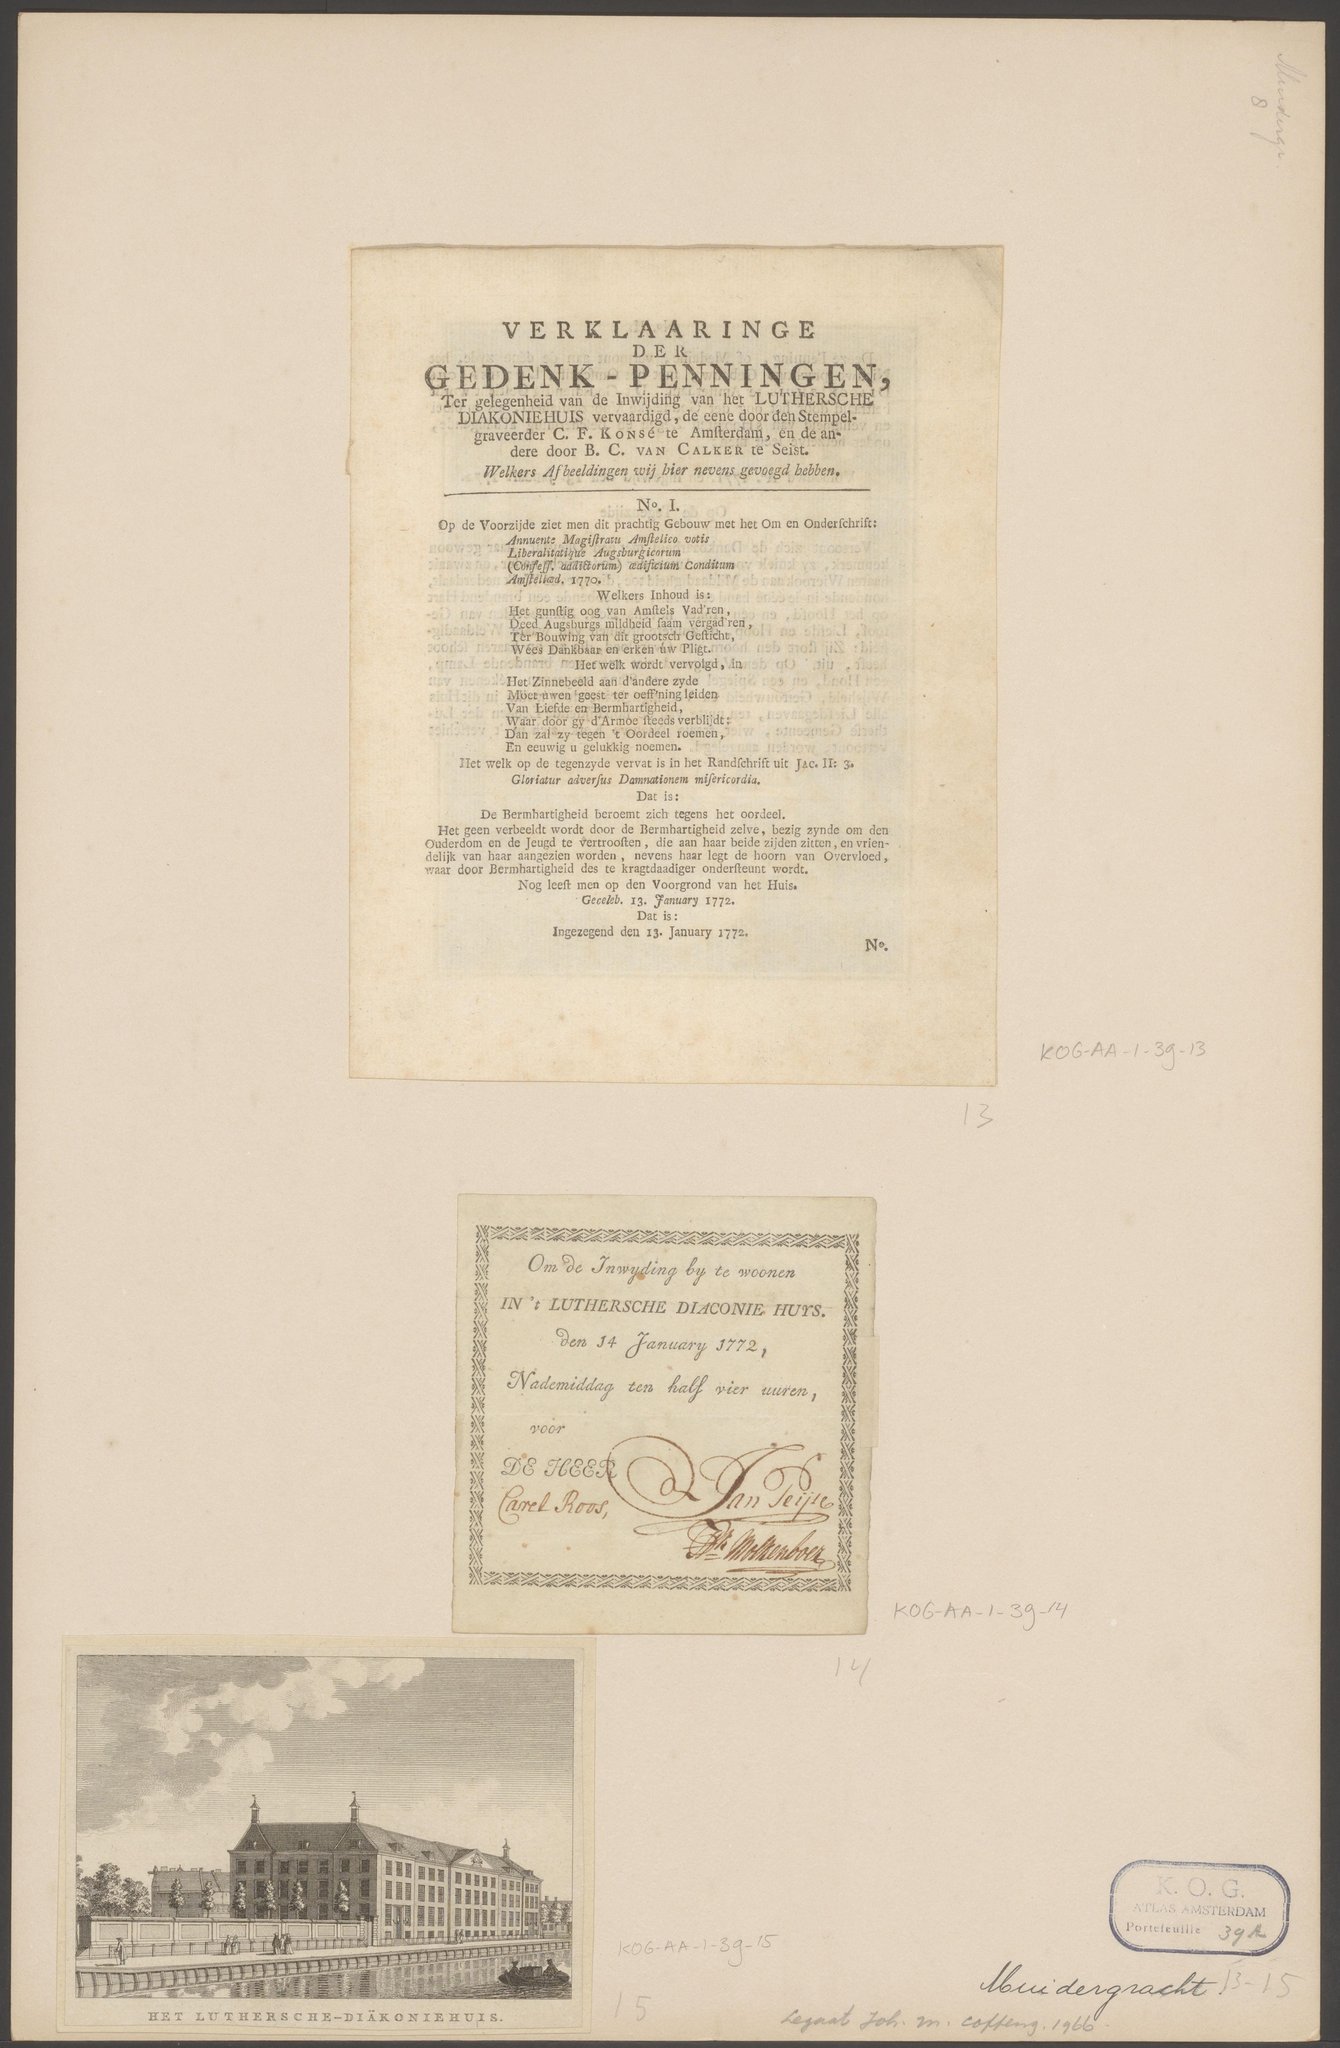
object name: invitation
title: Uitnodiging voor de inwijding van het Lutherse Diaconiehuis te Amsterdam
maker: Anonymous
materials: paper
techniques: letterpress printing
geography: northern netherlands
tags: old-people's home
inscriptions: collector's mark: Lugt 1641b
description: Onderwerpsrubriek binnen de Atlas Amsterdam: Armwezen en liefdadige instellingen: II. Kerkelijke inrichtingen: Inrichtingen der Evang. Luthersen.